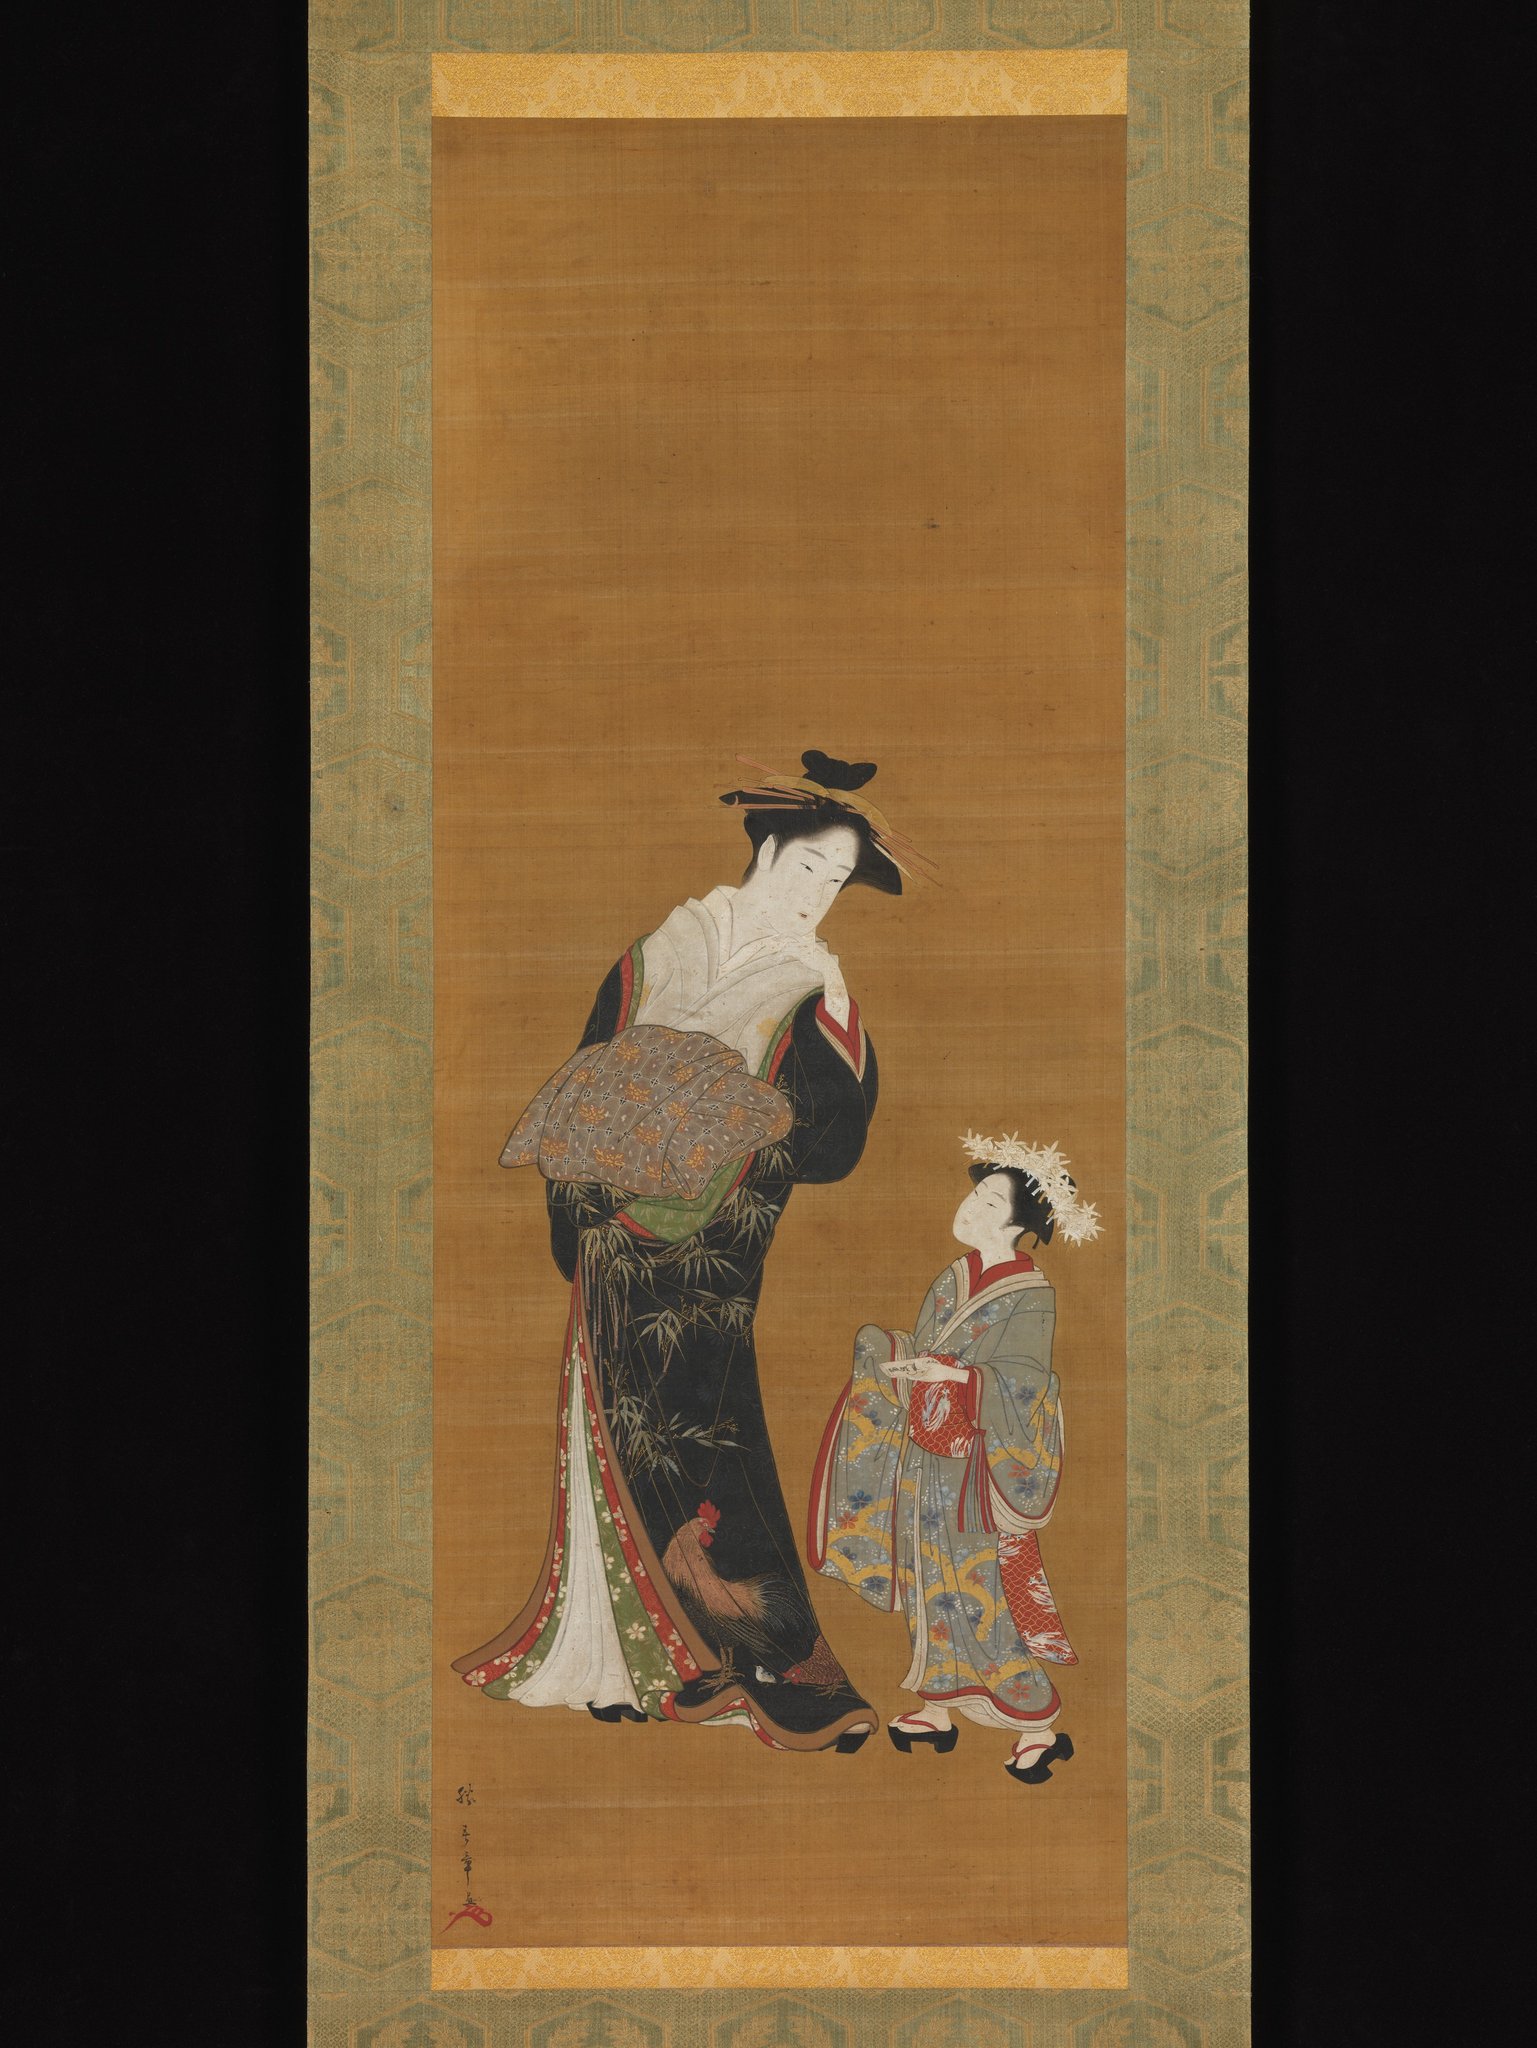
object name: hanging scroll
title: Courtesan and Her Attendant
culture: japanese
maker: katsukawa shunshō 勝川春章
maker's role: artist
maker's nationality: japanese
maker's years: 1726-1792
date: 1701-1800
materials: ink, silk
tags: women